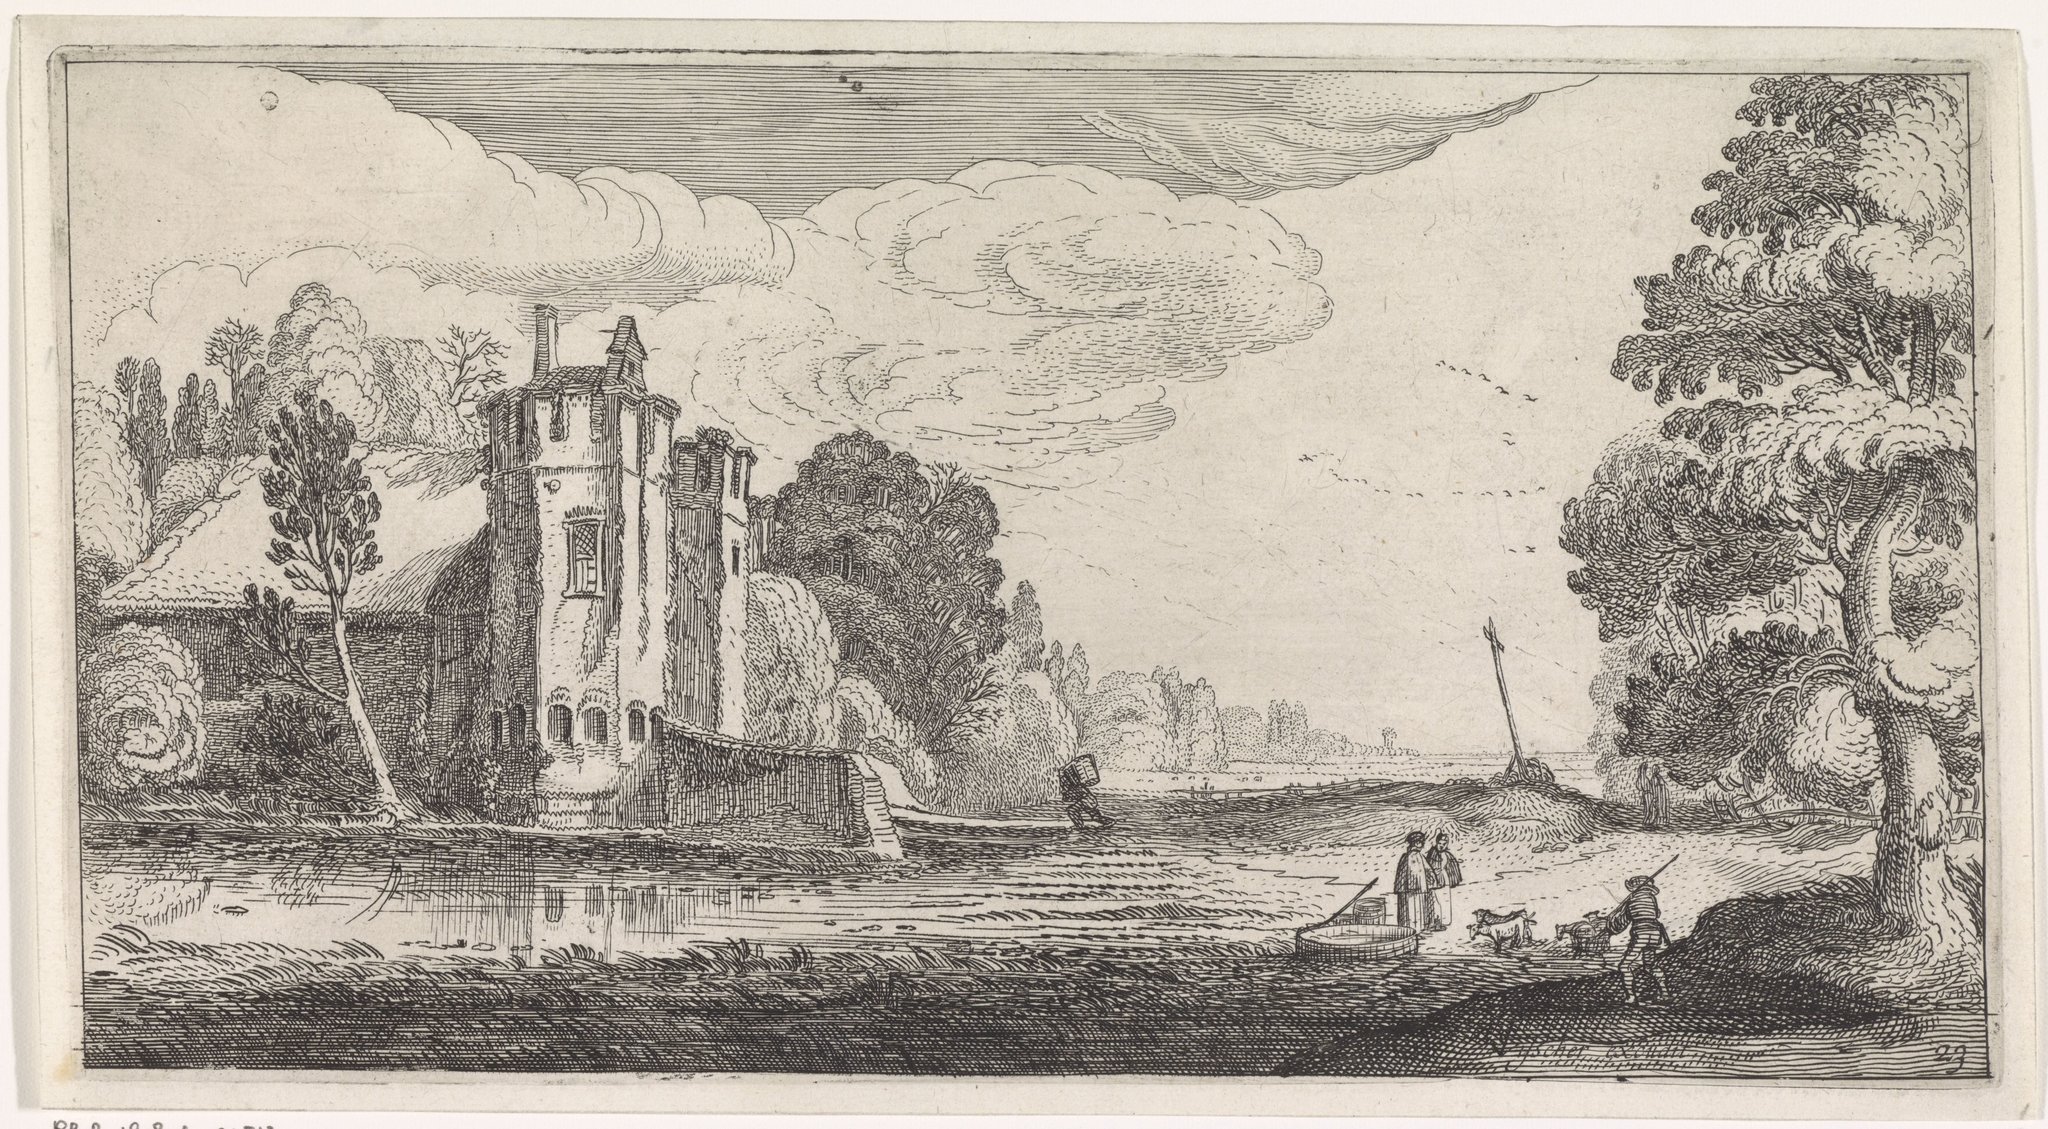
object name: print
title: Landschap met figuren bij een versterkt huis met twee torens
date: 1639-1641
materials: paper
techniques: etching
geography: northern netherlands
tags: landscape with tower or castle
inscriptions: collector's mark: Lugt 964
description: Bij Franken & Van der Kellen tweemaal gecatalogiseerd onder nummer 395 en 411. De derde staat van de prent behoort tot de serie 'Playsante lantschappen ende vermakelycke gesichten'.